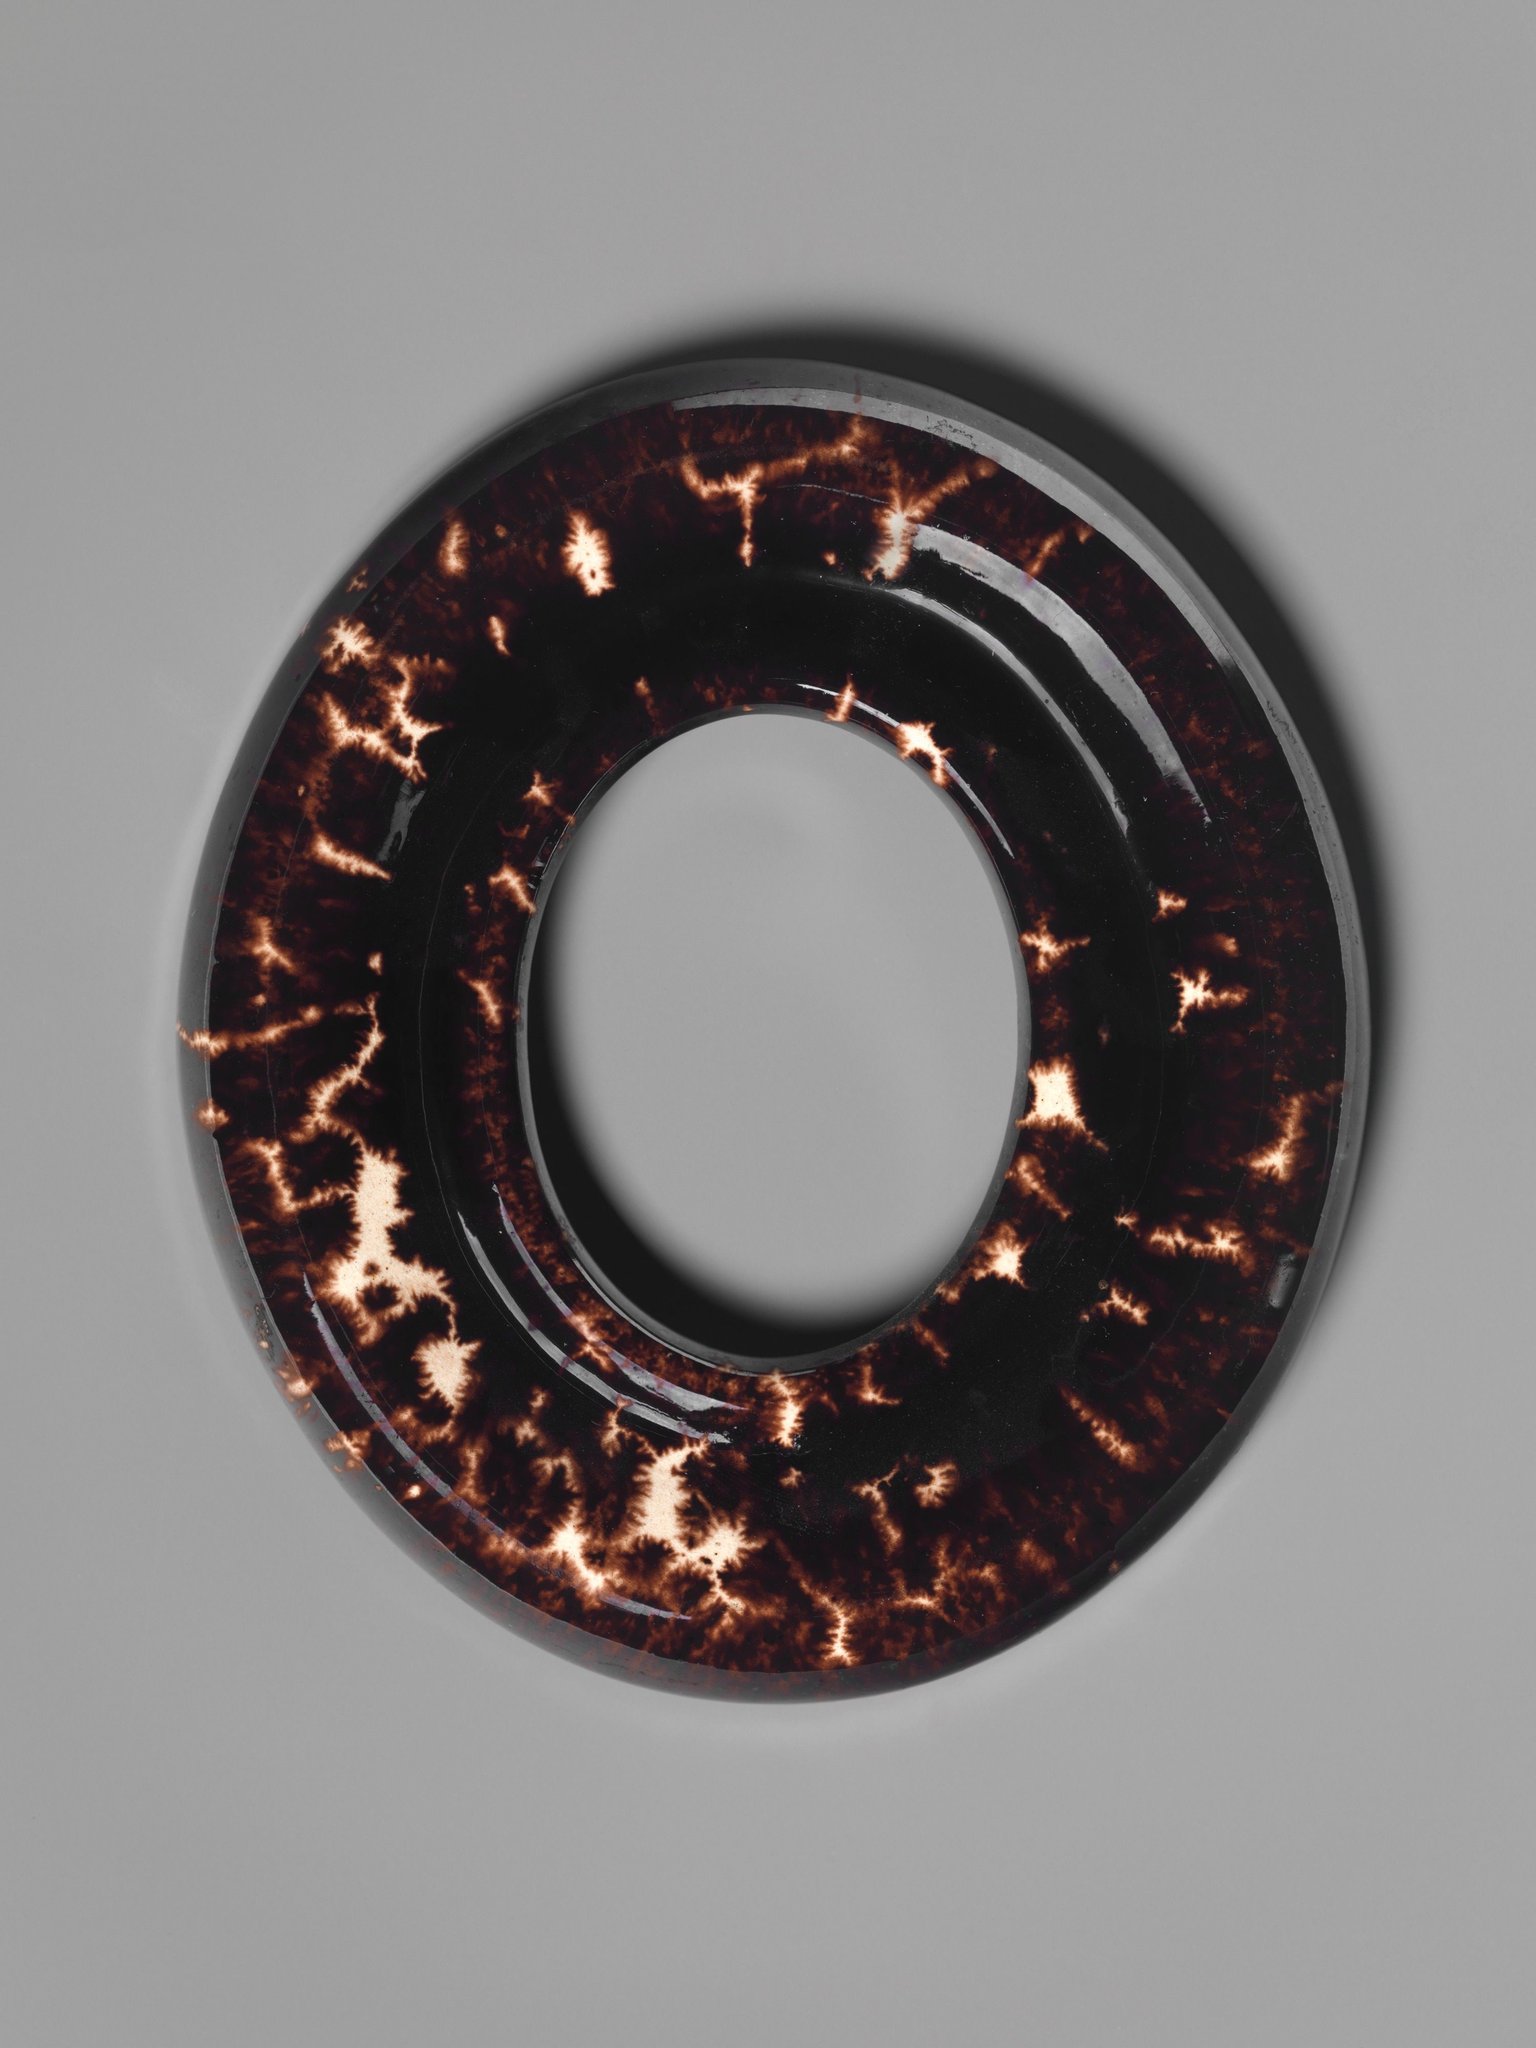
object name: frame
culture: american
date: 1830-1870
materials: earthenware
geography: united states